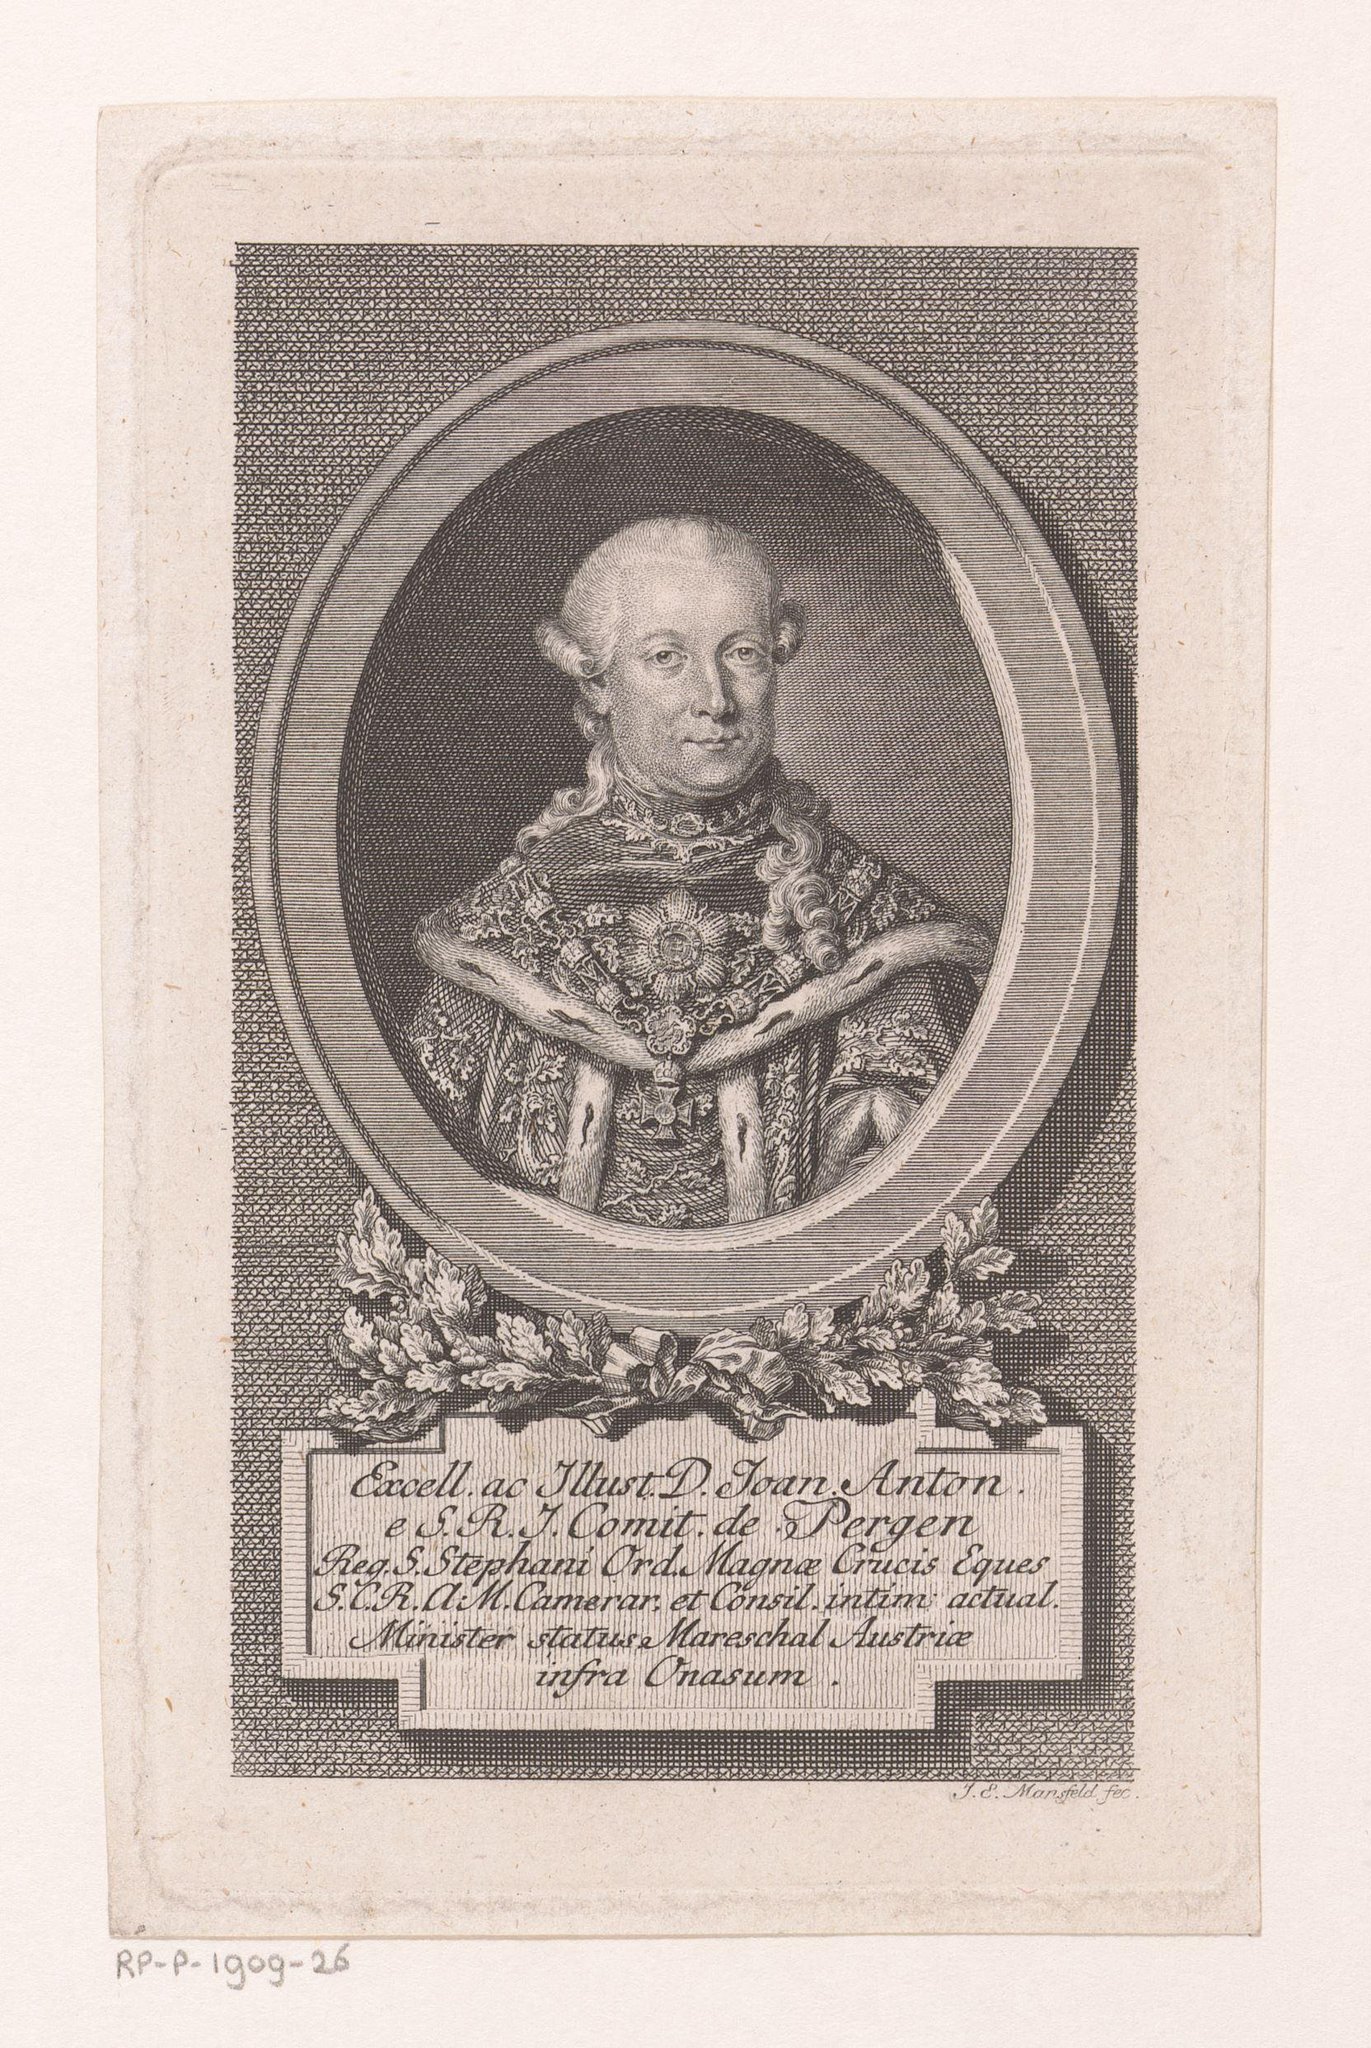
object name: print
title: Portret van Johann Anton von Pergen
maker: johann ernst mansfeld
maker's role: print maker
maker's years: 1739-1796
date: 1749-1796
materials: paper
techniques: engraving, etching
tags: vienna, historical persons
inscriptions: collector's mark: Lugt 2228